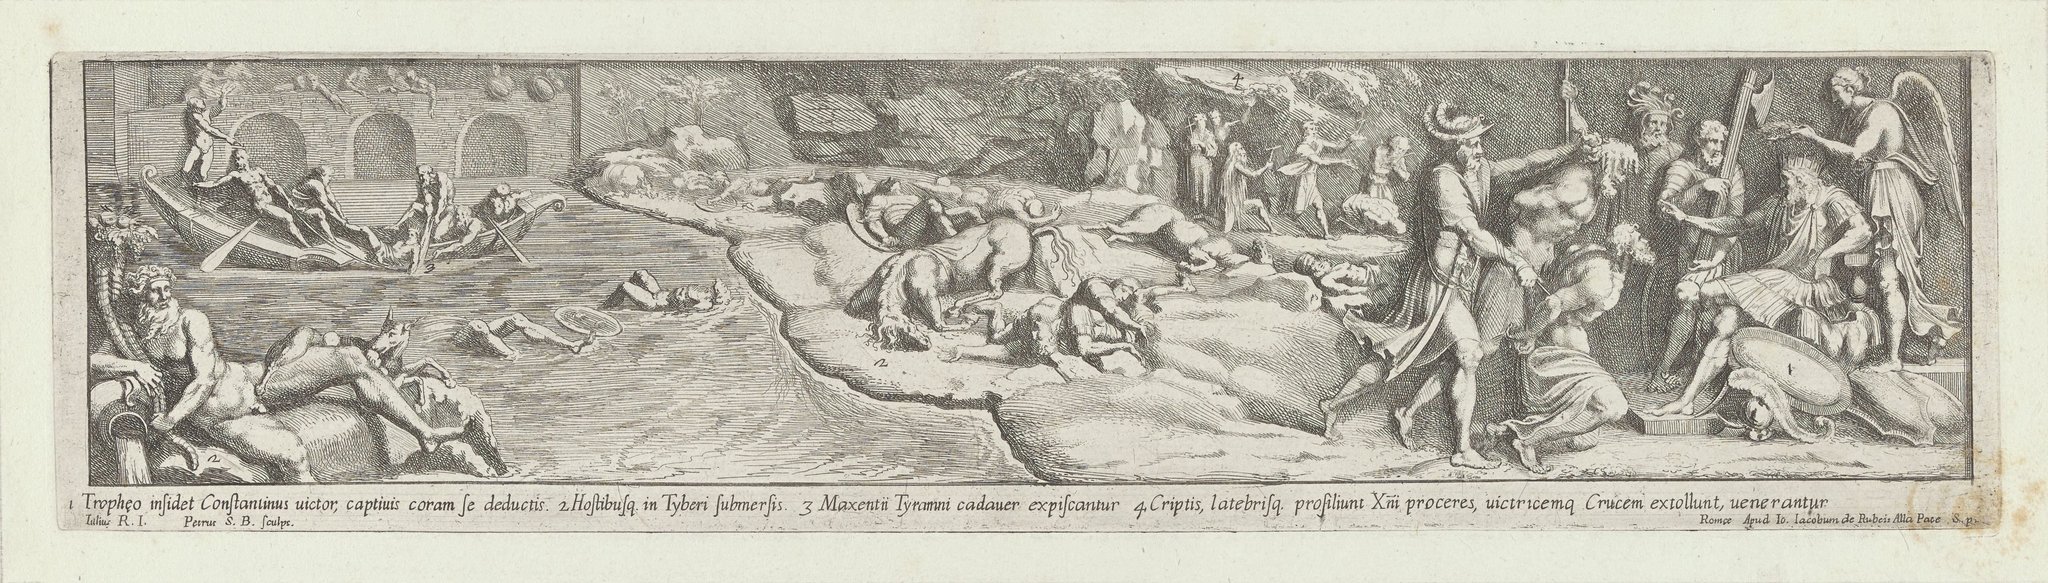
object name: print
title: Nasleep van de Slag bij de Milvische brug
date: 1645-1700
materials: paper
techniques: engraving, etching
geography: italy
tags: the soldier; the soldier's life, the roman emperor constantine the great; possible attributes: crown, sceptre, standard (labarum) with chi-rho monogram or cross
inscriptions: collector's mark: Lugt 240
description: De nasleep van de Slag bij de Milvische brug (28-10-312). Rechts Keizer Constantijn die wordt gekroond door Victorie en luistert naar de gevangenen die voor hem worden gebracht. Centraal liggen en drijven dode paarden en soldaten. Links wordt het dode lichaam van Maxentius uit de rivier gehaald. Op de voorgrond links een liggende riviergod. Legenda in ondermarge.